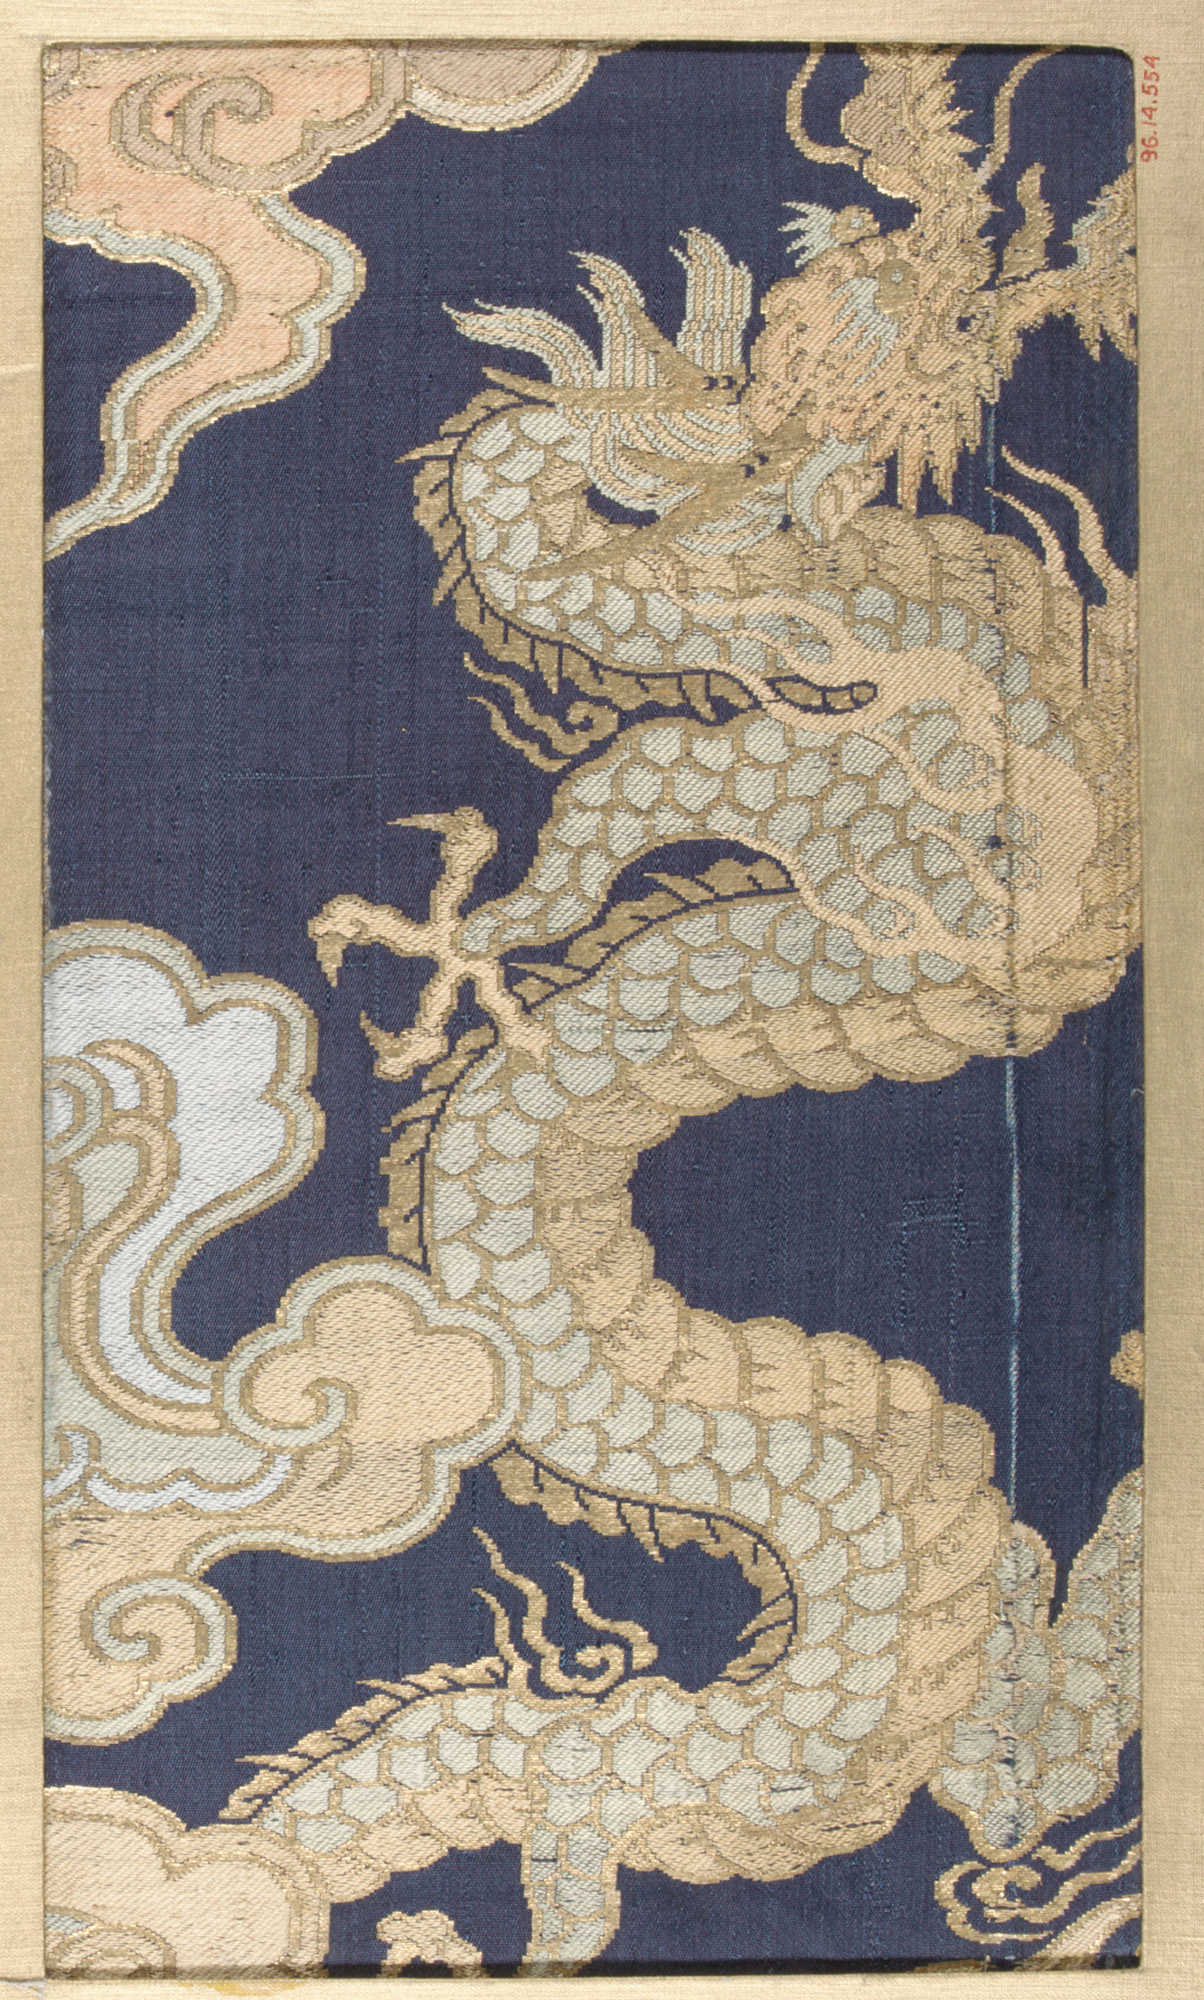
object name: piece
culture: japanese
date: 1701-1900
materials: silk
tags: dragons